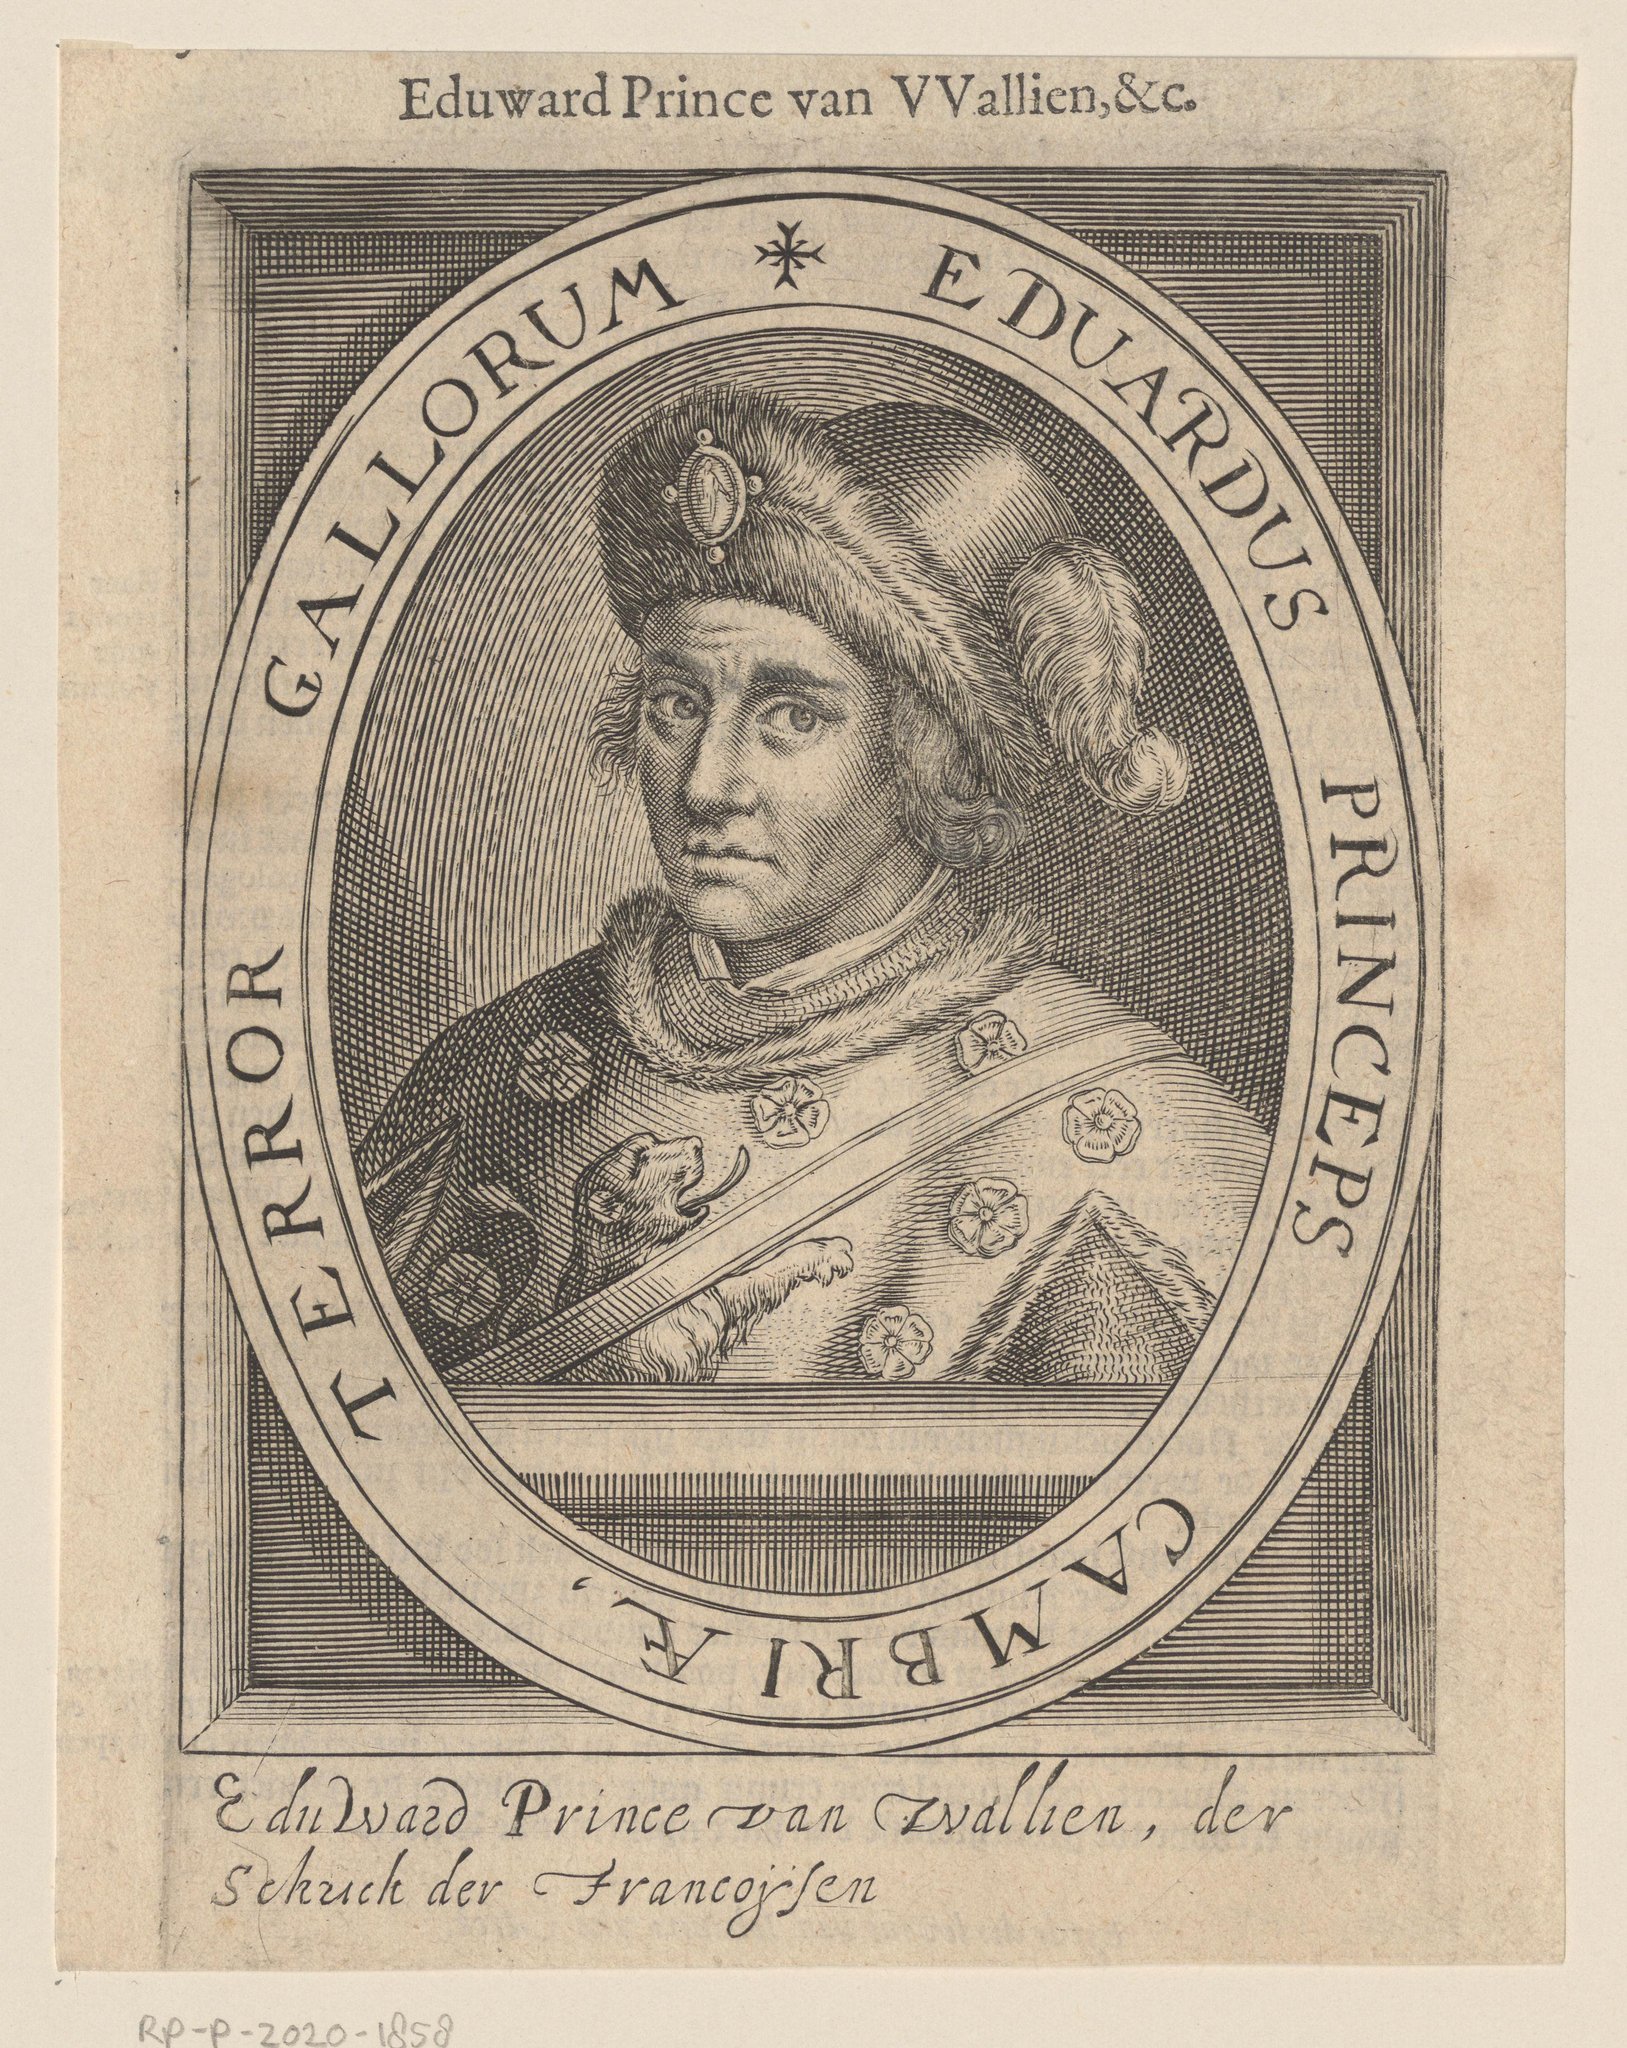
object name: print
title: Portret van Eduard van Woodstock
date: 1617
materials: paper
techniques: engraving, letterpress printing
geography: delft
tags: prince, historical persons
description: Prent uit: Tooneel der beroemder hertogen princen graven ende krygs-helden van christenrijck binnen deze drij laetste eeuwen. Delft: Nicolaes de Clerck, 1617, p. 586.